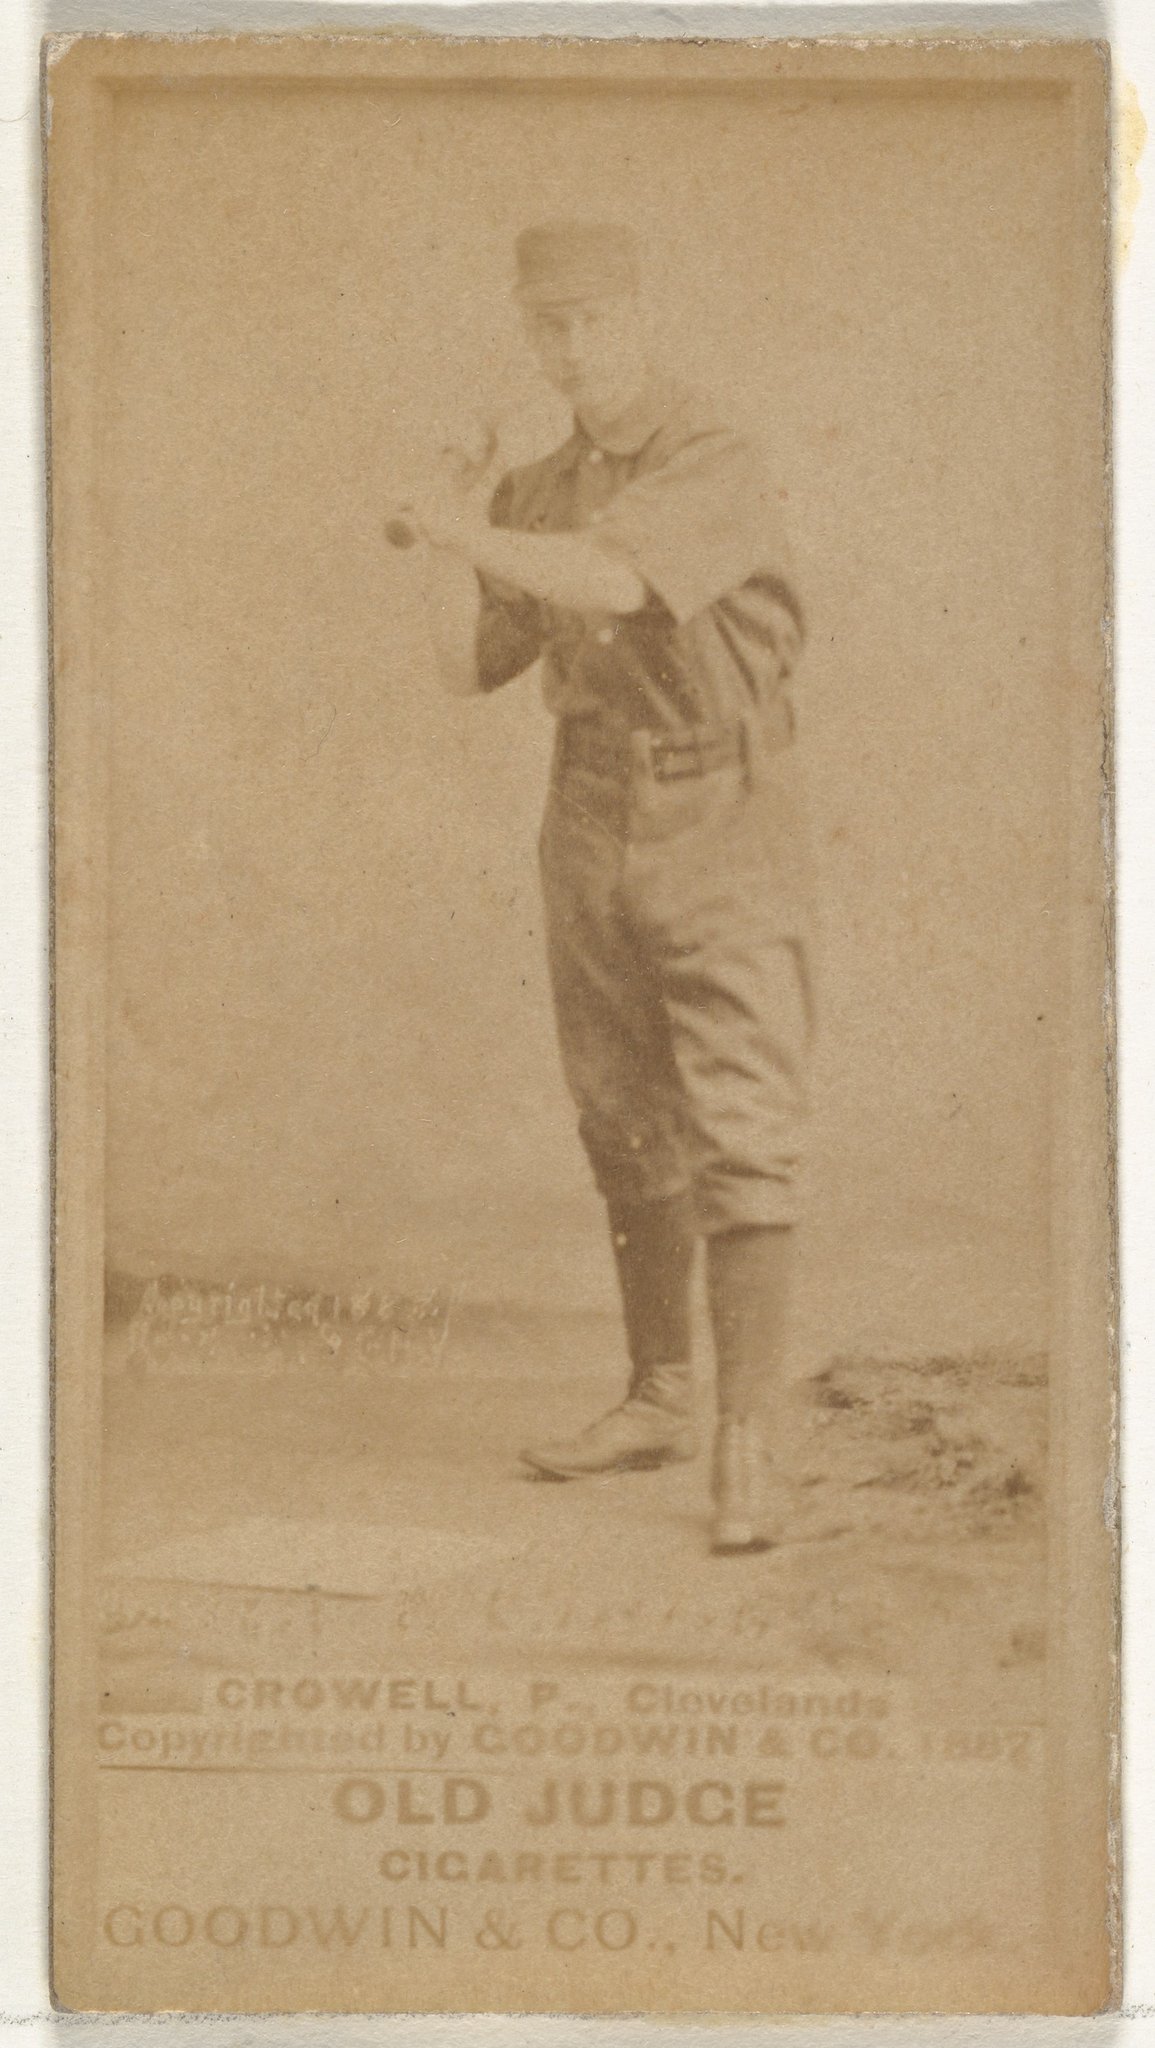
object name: baseball card, photograph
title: William Theodore "Billy" Crowell, Pitcher, Cleveland, from the Old Judge series (N172) for Old Judge Cigarettes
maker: goodwin & company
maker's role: publisher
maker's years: 1850-1950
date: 1887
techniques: albumen silver print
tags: men,portraits,baseball,athletes